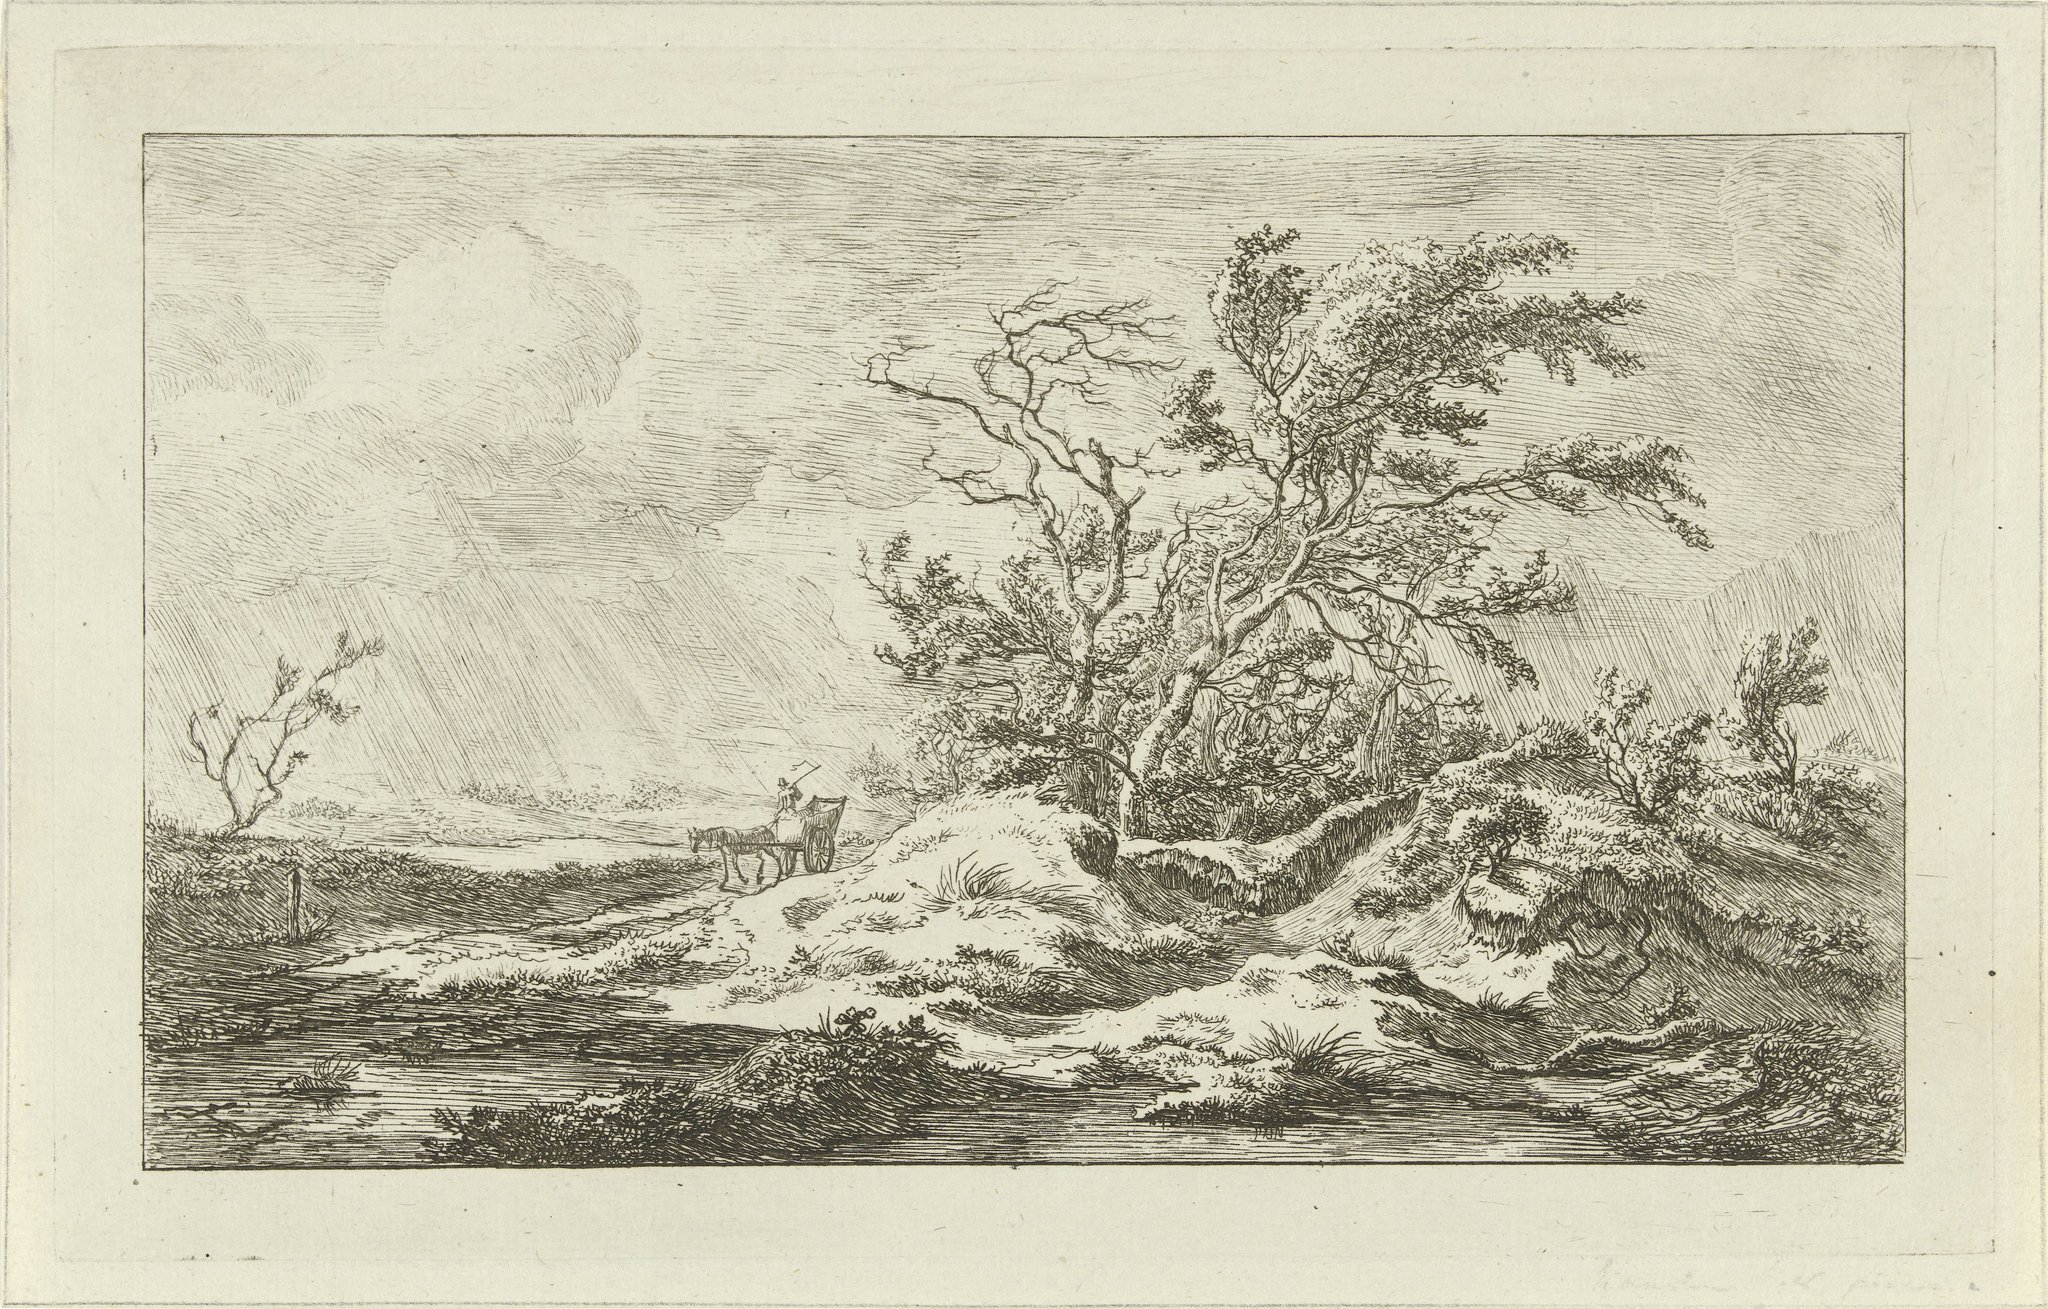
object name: print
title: Paard met wagen in een landschap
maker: carel lodewijk hansen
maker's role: draughtsman, painter, print maker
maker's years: 1765-1840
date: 1780-1840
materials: paper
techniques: etching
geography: netherlands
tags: rain, landscapes (+ landscape with figures, staffage), two-wheeled vehicle drawn by one animal, haarlem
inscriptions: collector's mark: Lugt 2228